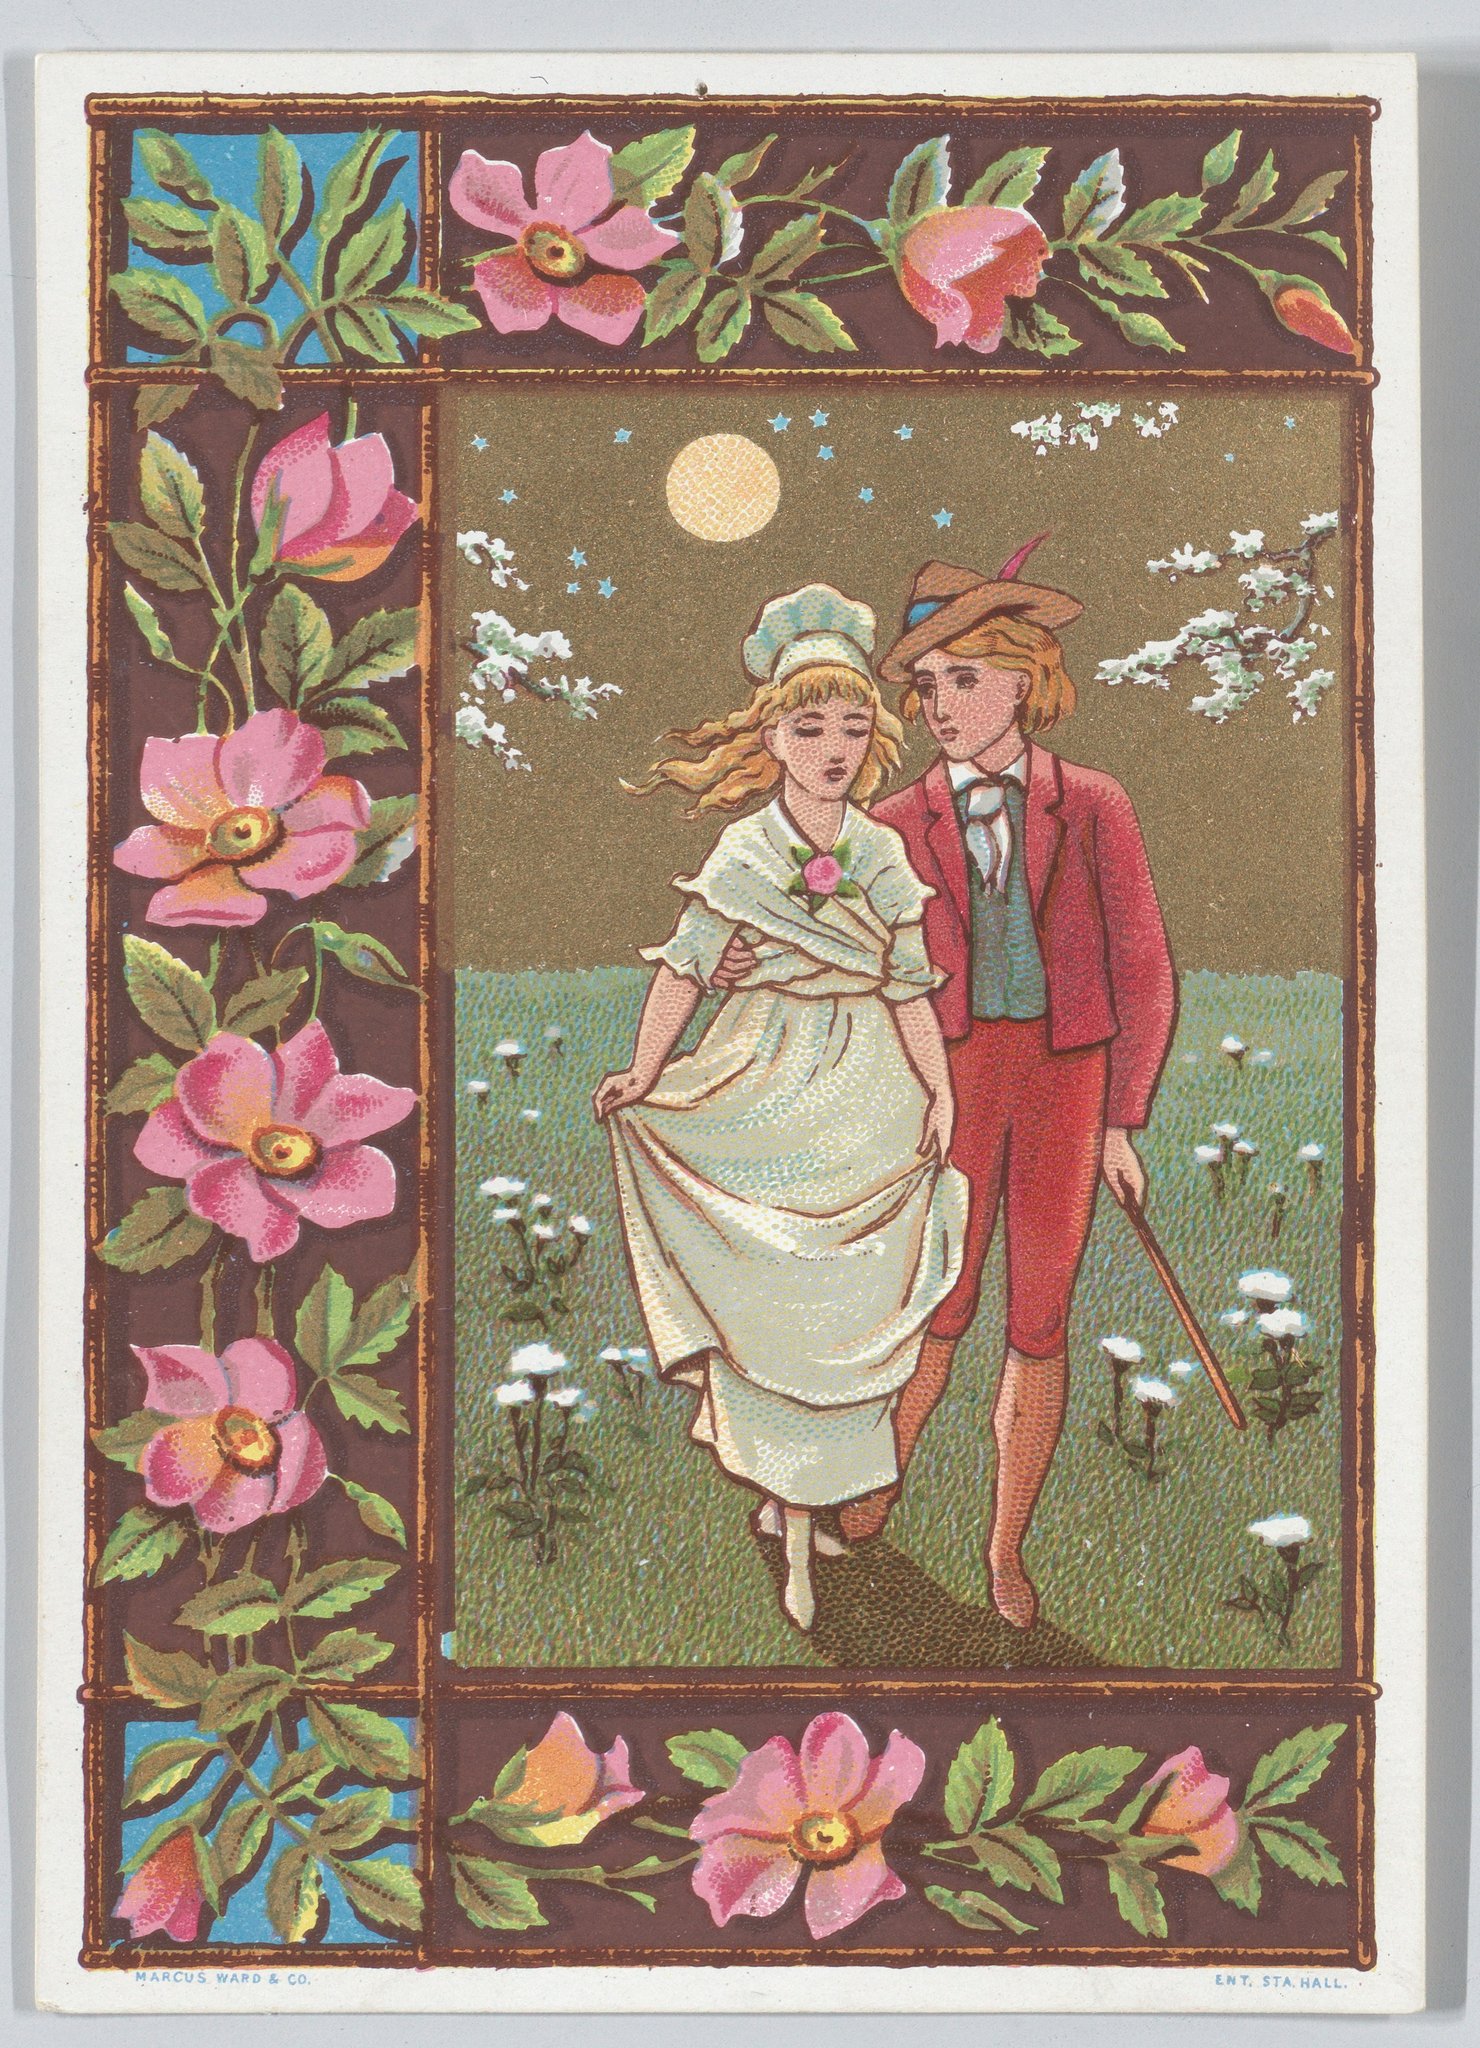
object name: valentine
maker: kate greenaway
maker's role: artist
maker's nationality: british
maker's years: 1846-1901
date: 1876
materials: gold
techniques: chromolithography, lithograph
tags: men,women